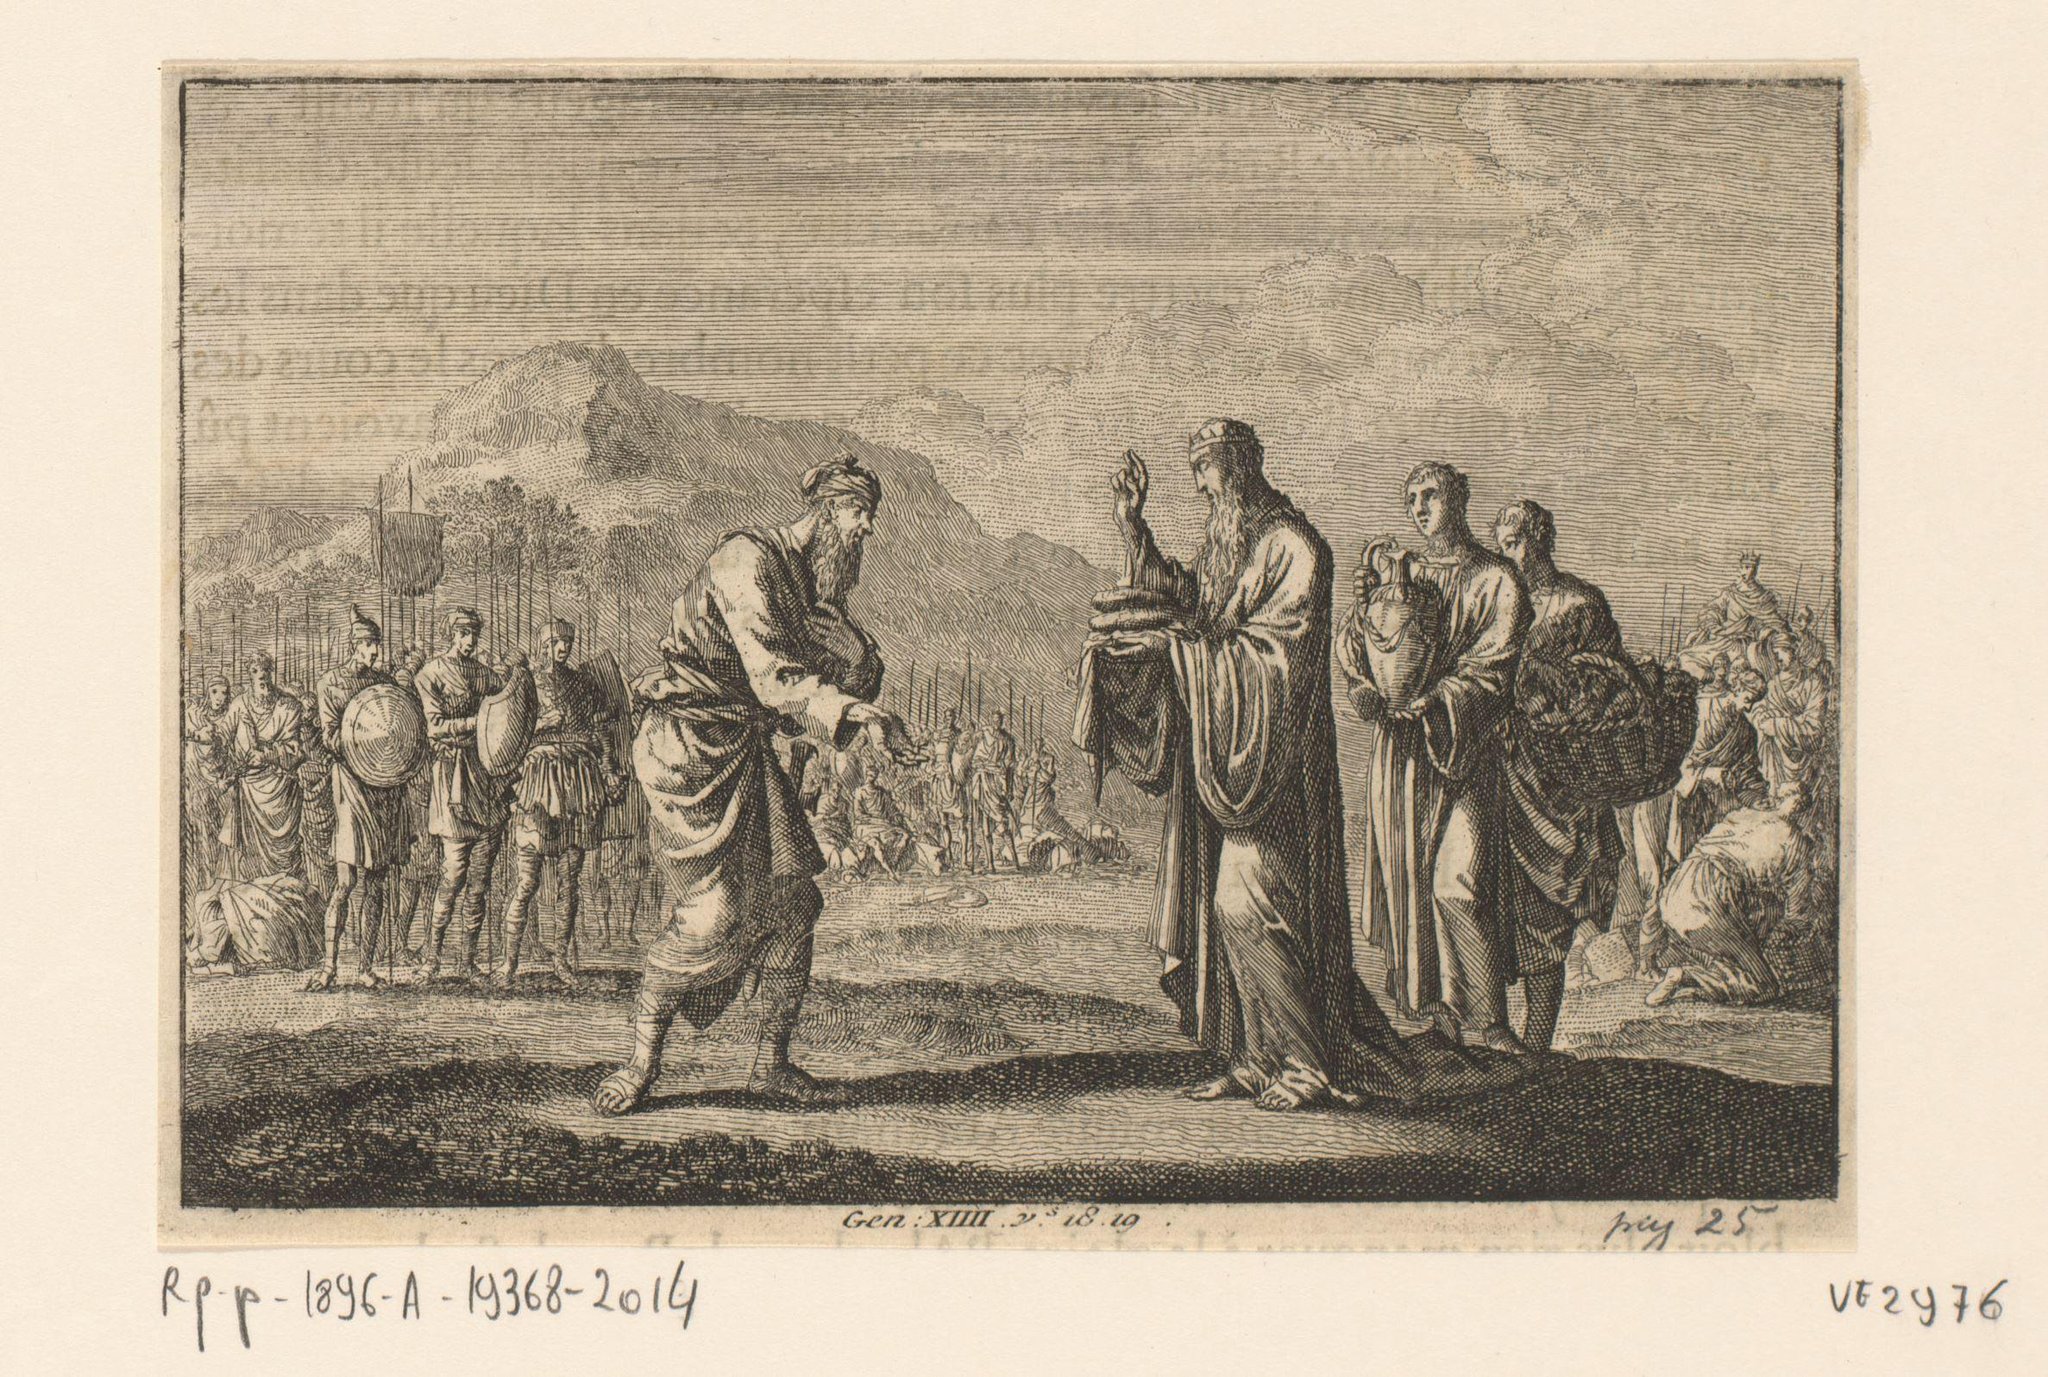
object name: print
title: Abraham ontmoet koning Melchisedek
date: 1703-1762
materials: paper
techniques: etching, letterpress printing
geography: haarlem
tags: the king of elam and three allied kings defeat the five rebellious kings of the pentapolis; in flight, two of the five kings fall into lime-pits and the three others escape to the mountains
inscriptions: collector's mark: Lugt 2228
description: De prent komt een eerste keer voor als boekillustratie voor David Martin. Historie des Ouden en Nieuwen Testaments. Amsterdam, Pieter Mortier, 1703. Deel I. De boekillustraties voor de Mortierbijbel hebben verschillende staten en kopieën, waarbij de chronologische volgorde moeilijk te achterhalen valt. Als boekillustraties werden ze bovendien herhaaldelijk opnieuw gebruikt voor andere boekwerken.